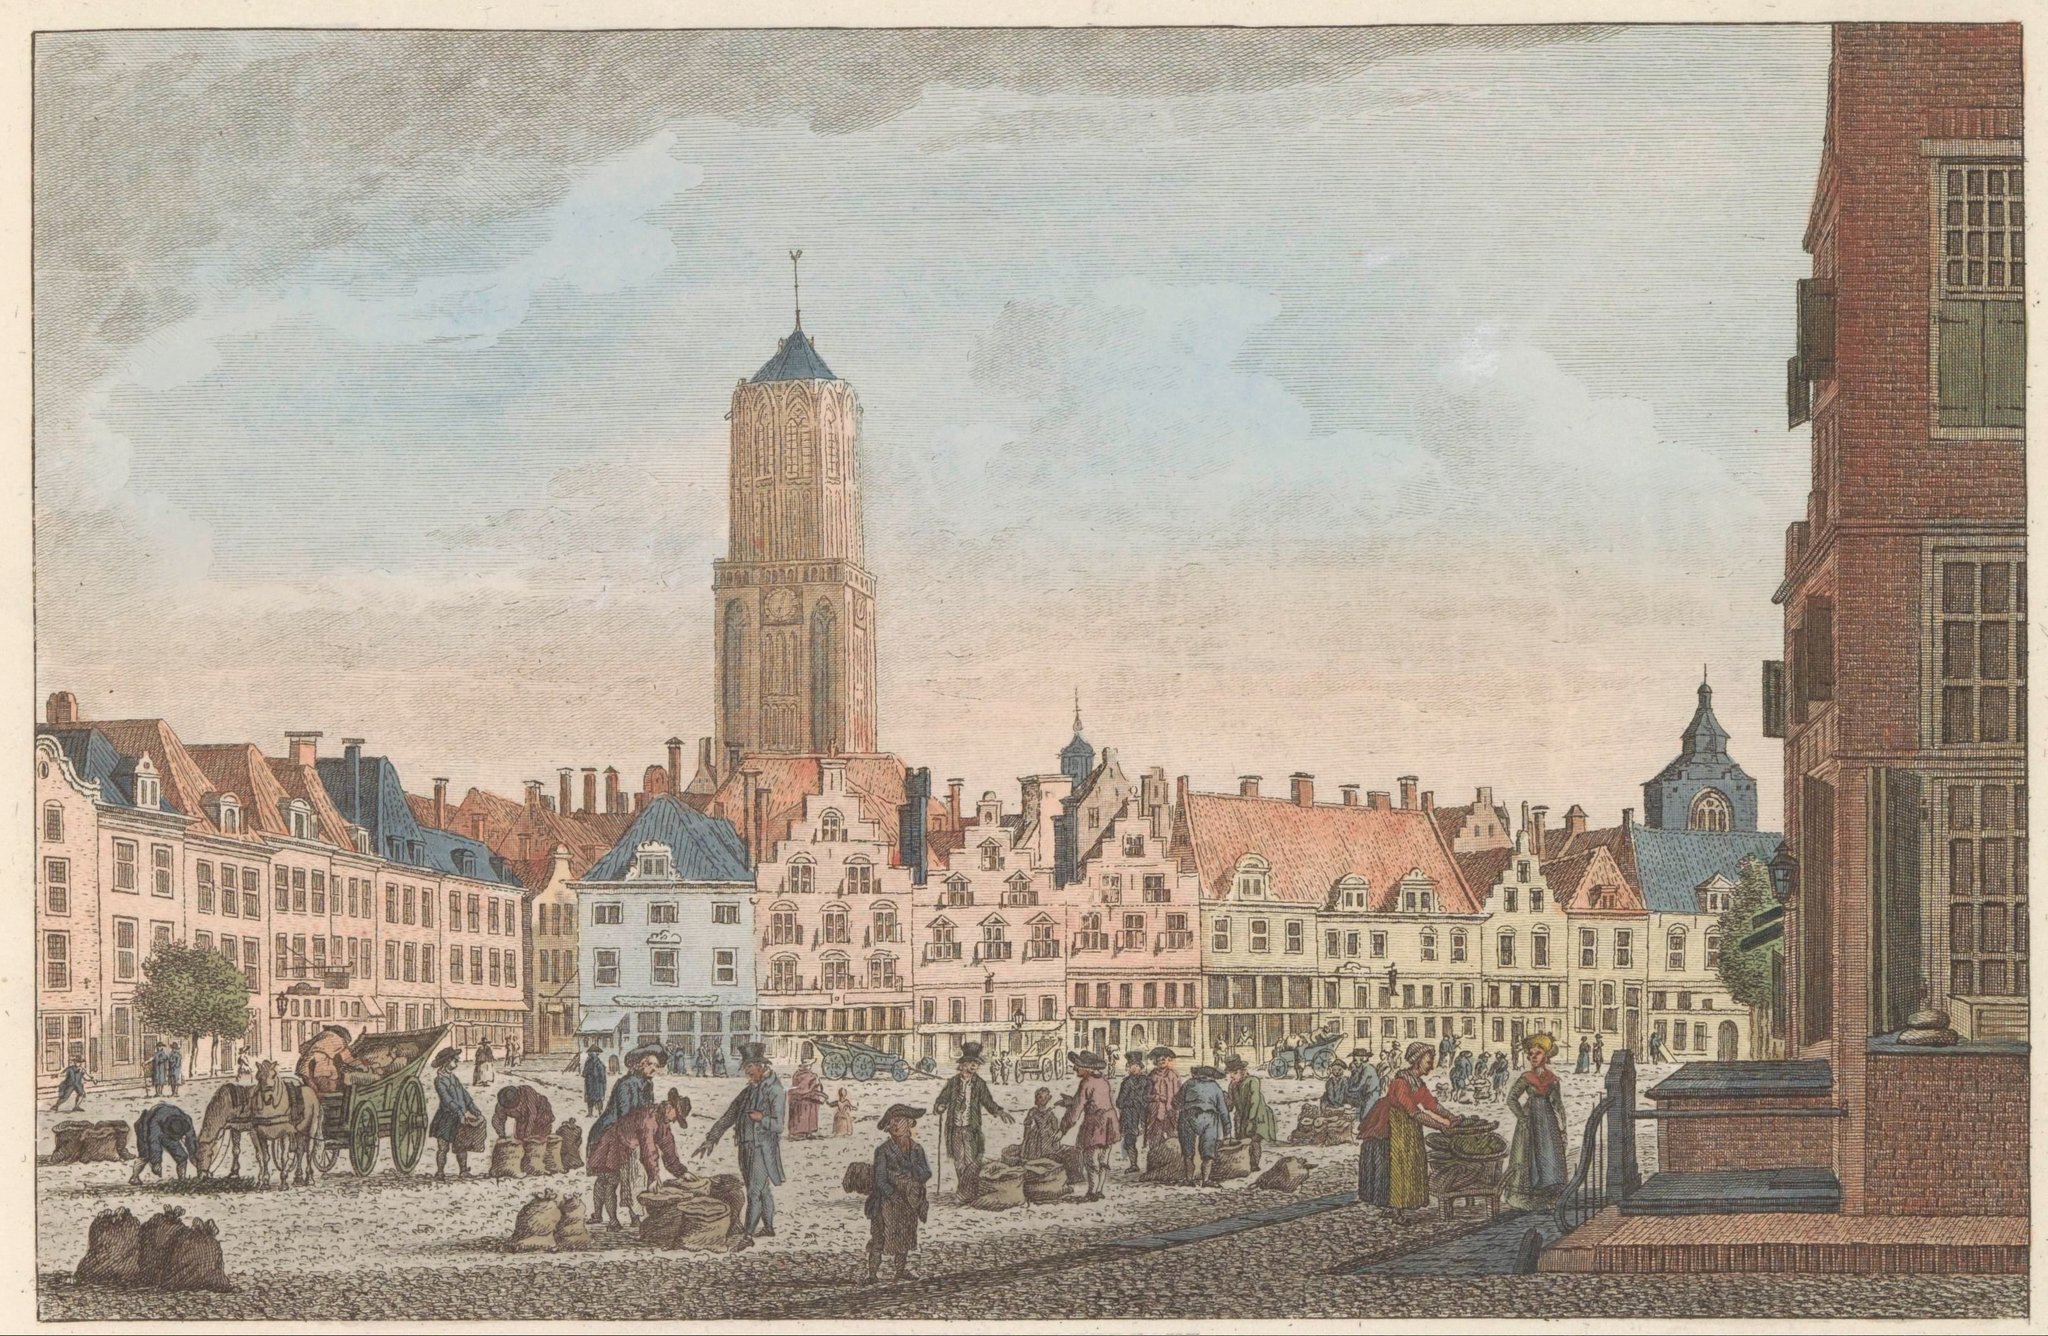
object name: print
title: De Neude te Utrecht / Marché dite Neude à Utrecht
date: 1786-1792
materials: paper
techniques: engraving, etching, hand coloring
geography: amsterdam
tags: utrecht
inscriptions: inscription: ‘Marché dite Neude à Utrecht’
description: Huidige staat van prent uitgegeven als onderdeel van een plaatwerk uit ca. 1824-1825 met 74 (ongenummerde) platen van de belangrijkste topografische gezichten en verschillende zeden en gewoonten in het Verenigd Koninkrijk der Nederlanden, getiteld 'Tableau des principales vues des palais et édifices : représentations et des coutumes et usages, dans les provinces septentrionales du Royaume des Pays-Bas'. Eerdere staat gebruikt in: Vaderlandsche gezichten, of afbeeldingen van den tegenwoordigen staat der Vereenigde Nederlanden (…). Amsterdam: Hendrik Gartman, Willem Vermandel en Jan Willem Smit, 1786-1792. Uitgegeven in afleveringen met ieder een eigen bifolium en inhoudsopgave. Alle prenten in deze publicatie zijn gegraveerd door Carel Frederik Bendorp (I) en, in de meeste gevallen, gebaseerd op tekeningen van Jan Bulthuis.